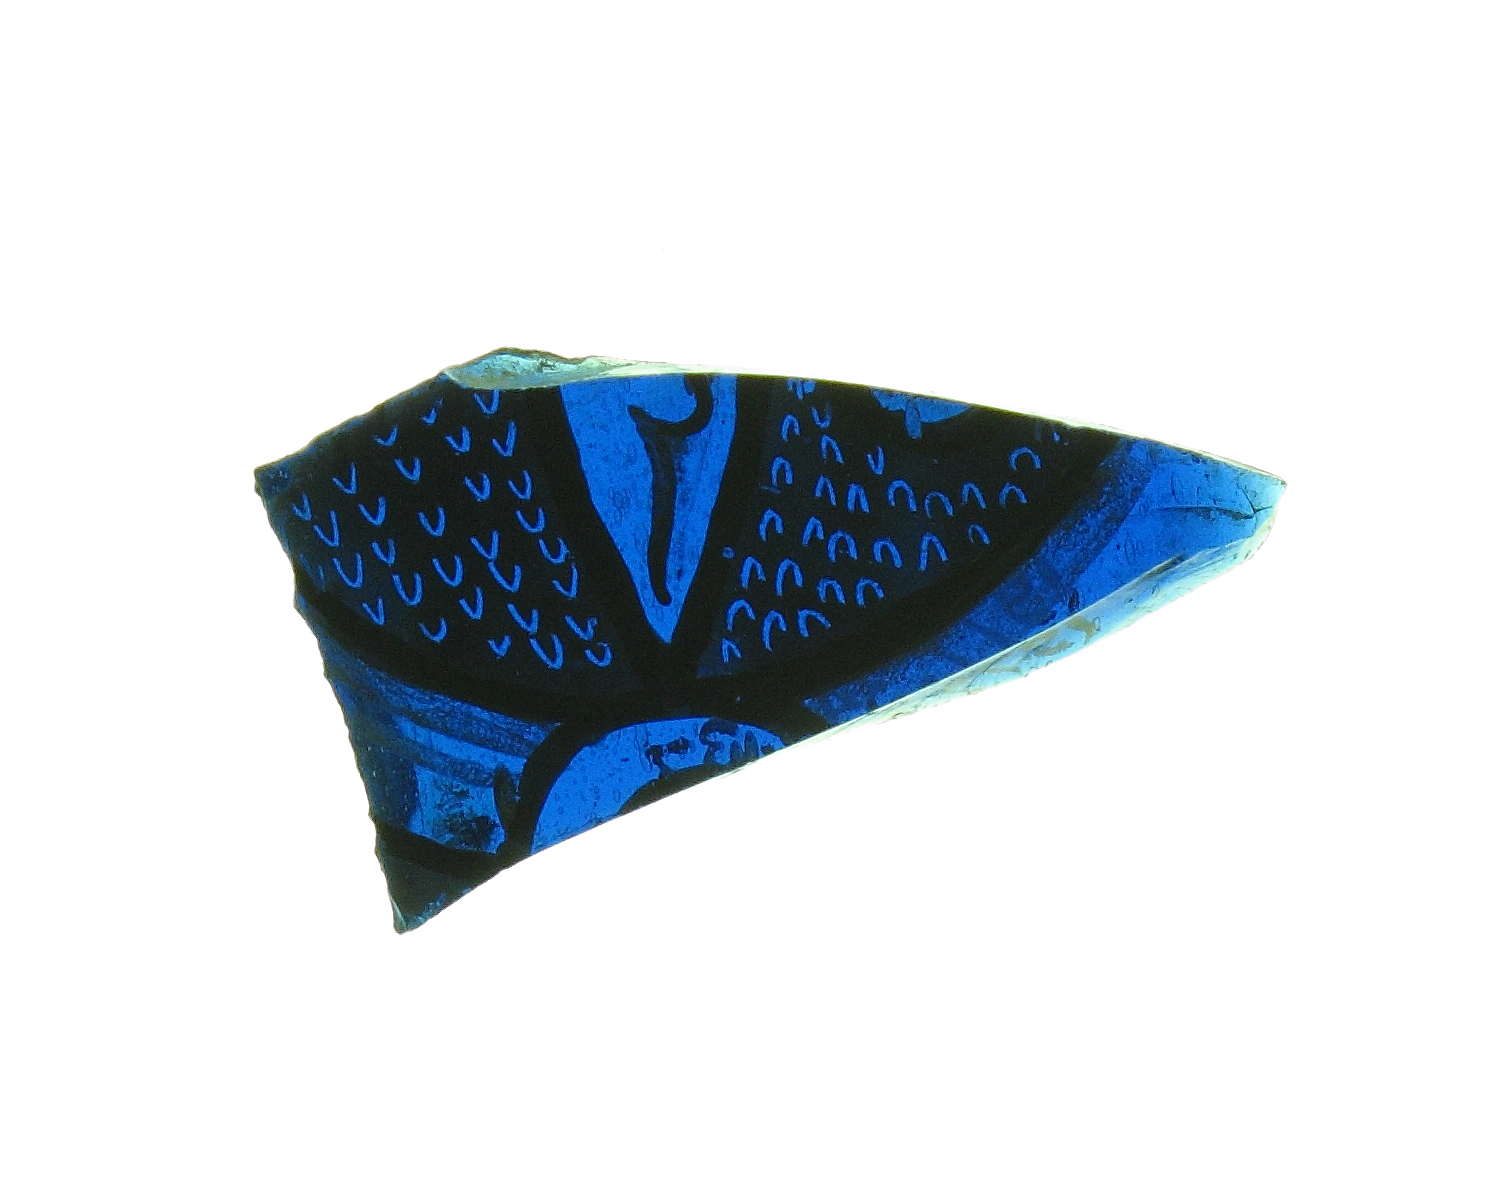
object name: fragment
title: Glass Fragment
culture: french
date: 1101-1400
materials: glass, metal, paint